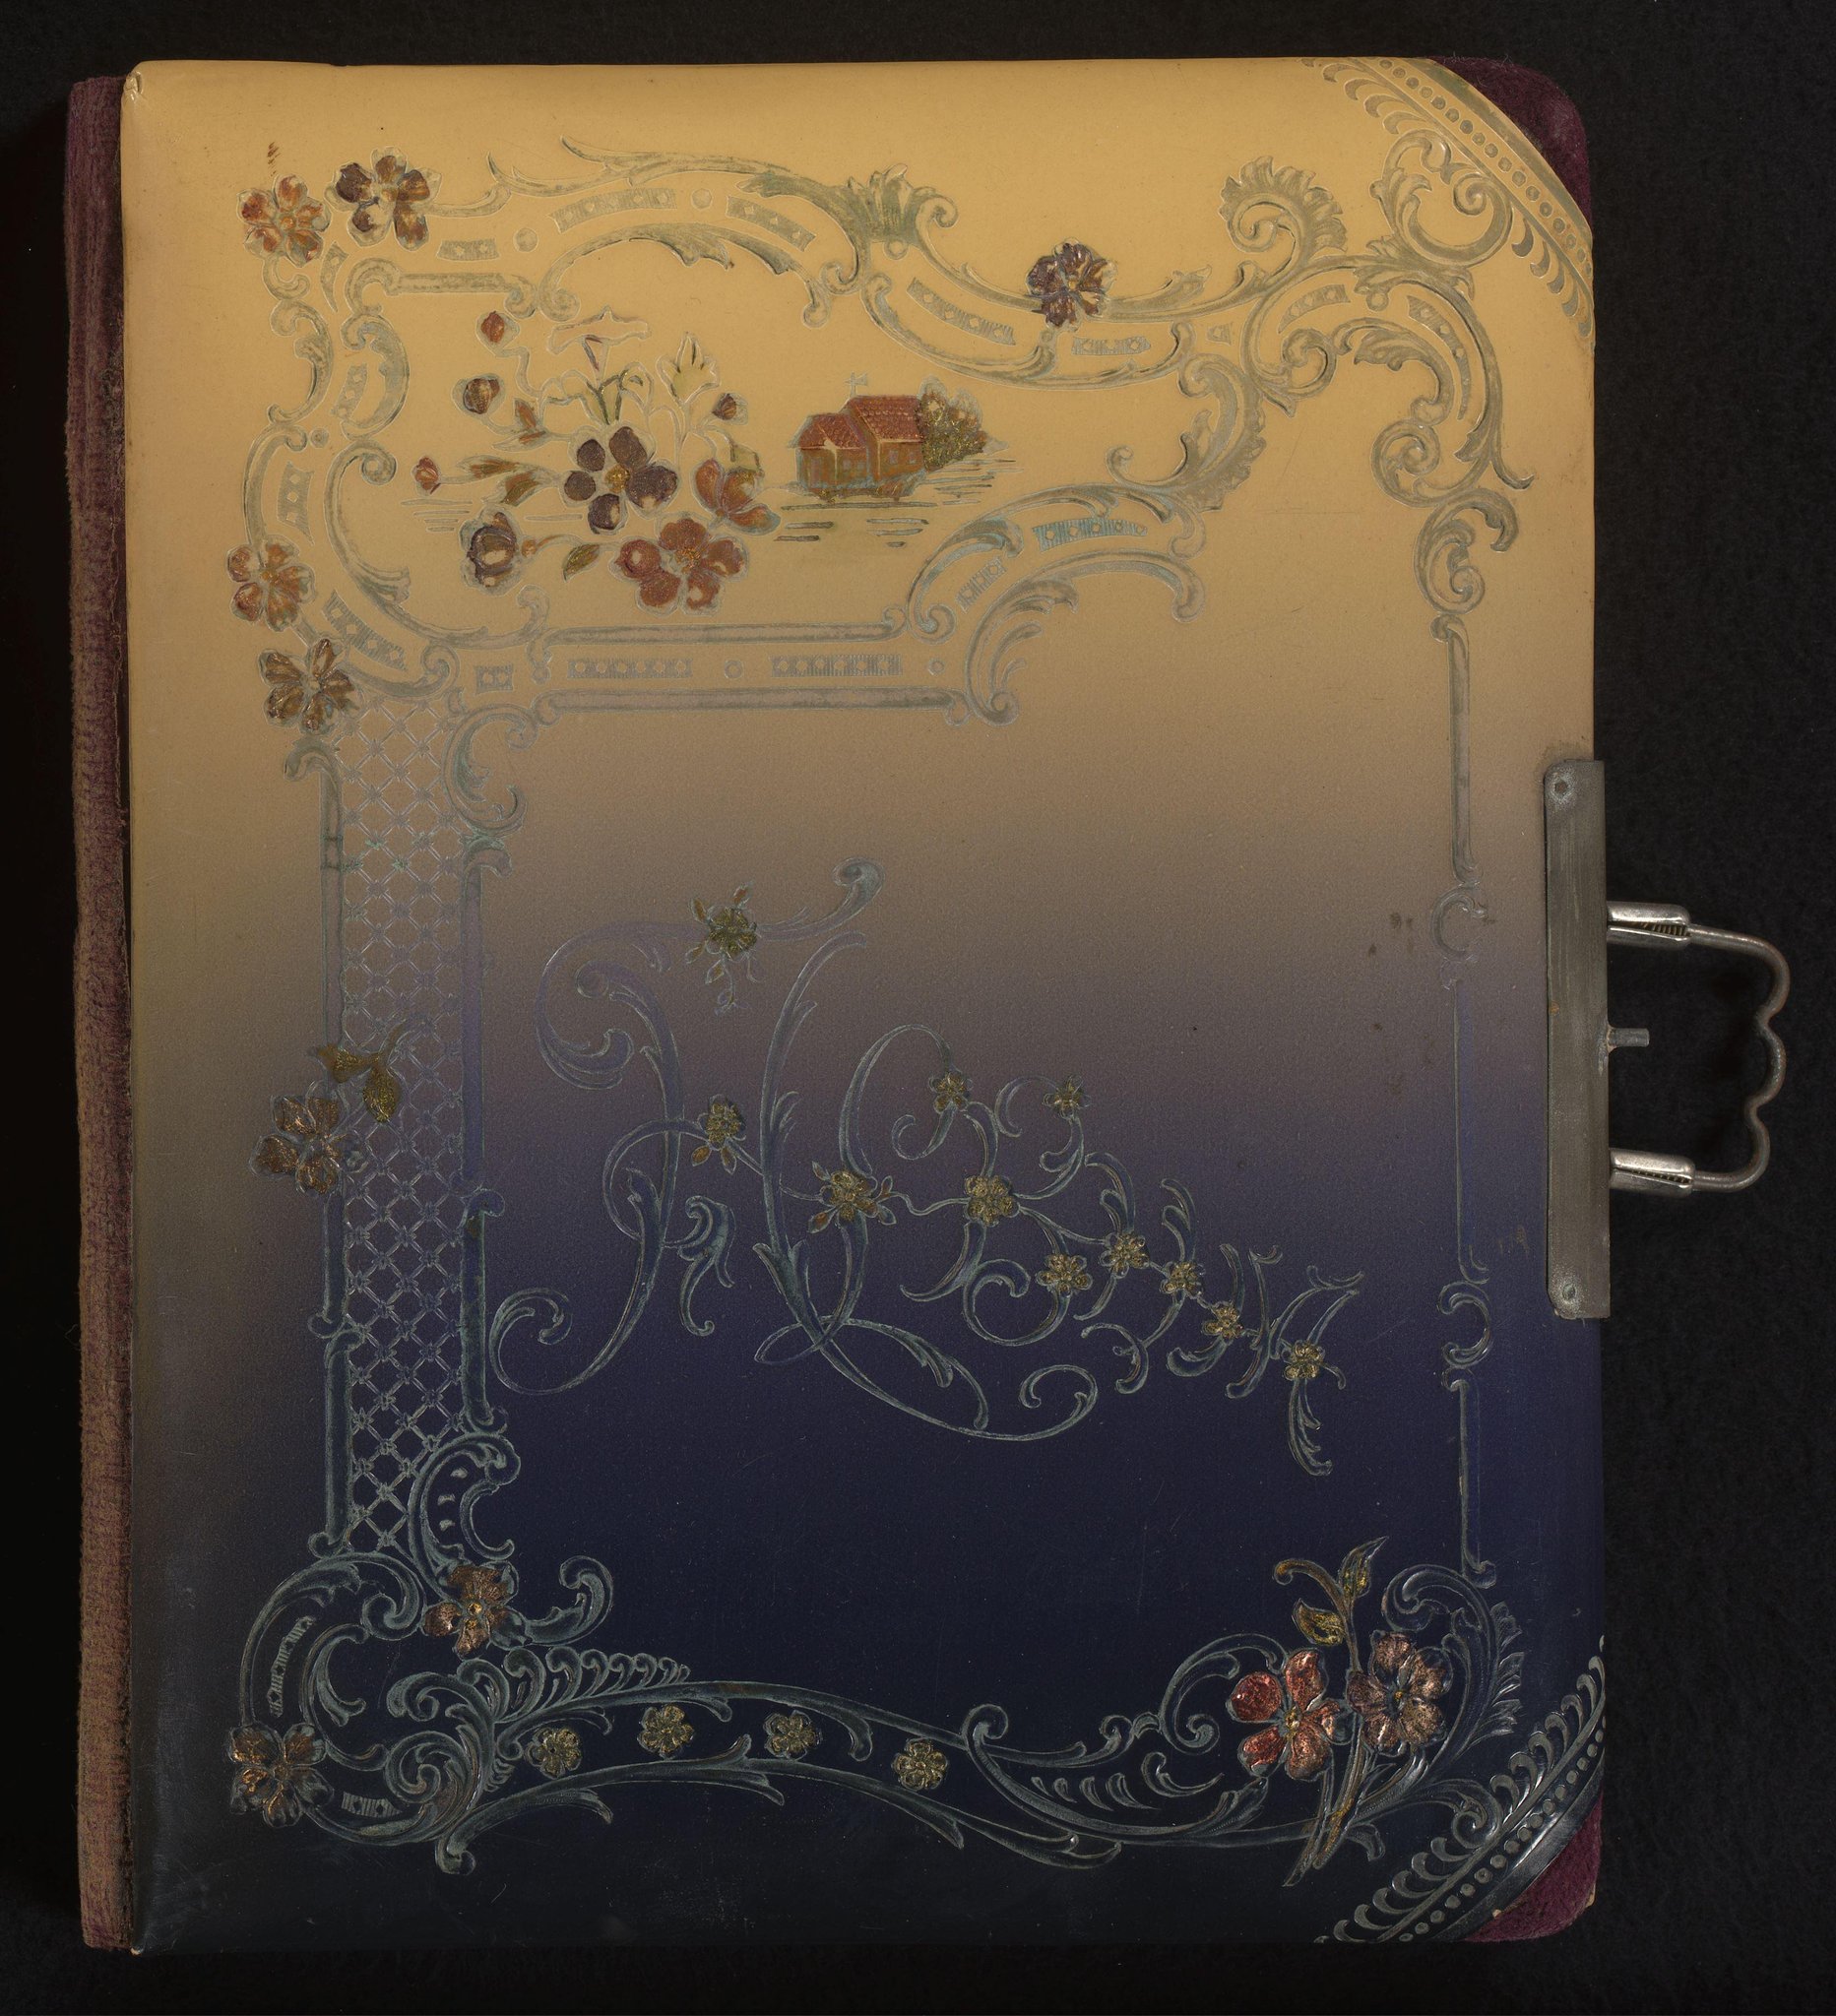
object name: photograph album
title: Album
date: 1860-1900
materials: cardboard, celluloid, metal, paper, photographic support, textile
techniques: albumen print, photograph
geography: amsterdam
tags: adult woman, madonna: i.e. mary with the christ-child, adult man, child, christ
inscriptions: collector's mark: ‘DIENST/ VERSPREIDE/ RIJKSKOLLEKTIES/ (...) A 701’, number: ‘6238/ IV’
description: Fotoalbum met in totaal 43 foto's en een fotomechanische afdruk op 24 pagina's. Het album bevat 8 kabinetfoto's en 36 cartes-de-visite in met gouden lijnen omkaderde passe-partouts. Afgebeeld zijn fotoreproducties van schilderijen van onder andere Rafaël, Peter Paul Rubens en Leonardo da Vinci. Van 21 foto's is de fotograaf anoniem. De overige foto's zijn gemaakt door diverse vervaardigers, waaronder Fratelli Alinari en Gustav Schauer.